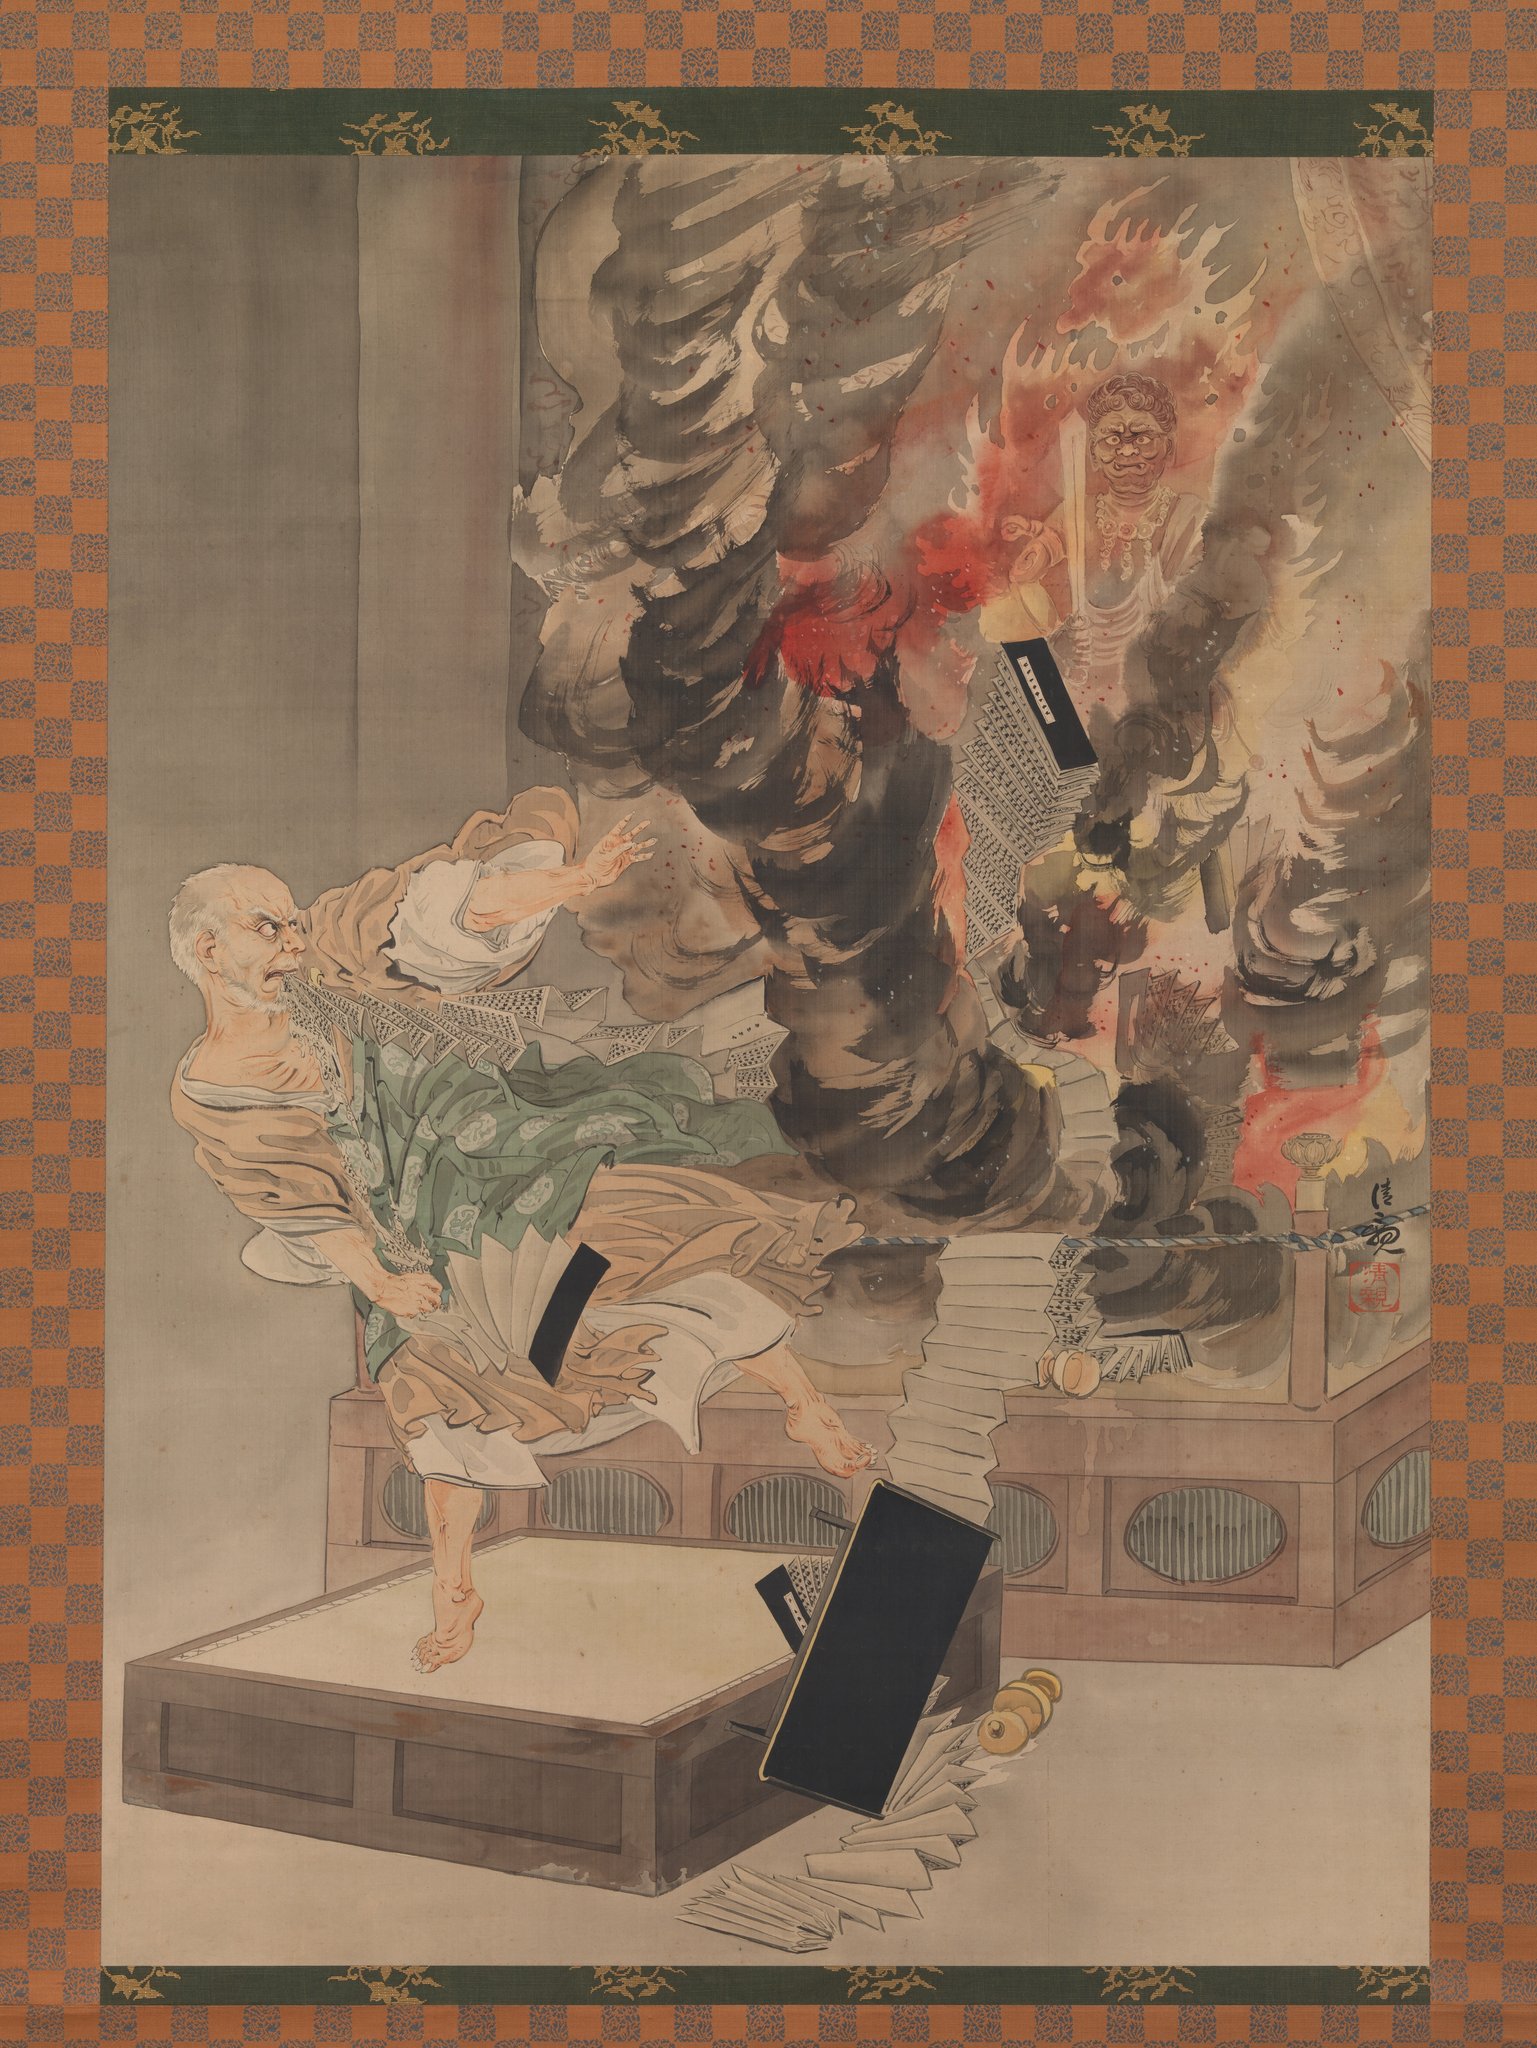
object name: hanging scroll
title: The Fury of Monk Raigō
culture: japanese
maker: kobayashi kiyochika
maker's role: artist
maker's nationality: japanese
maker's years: 1847-1915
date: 1900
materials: gold paint, ink, silk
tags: monks